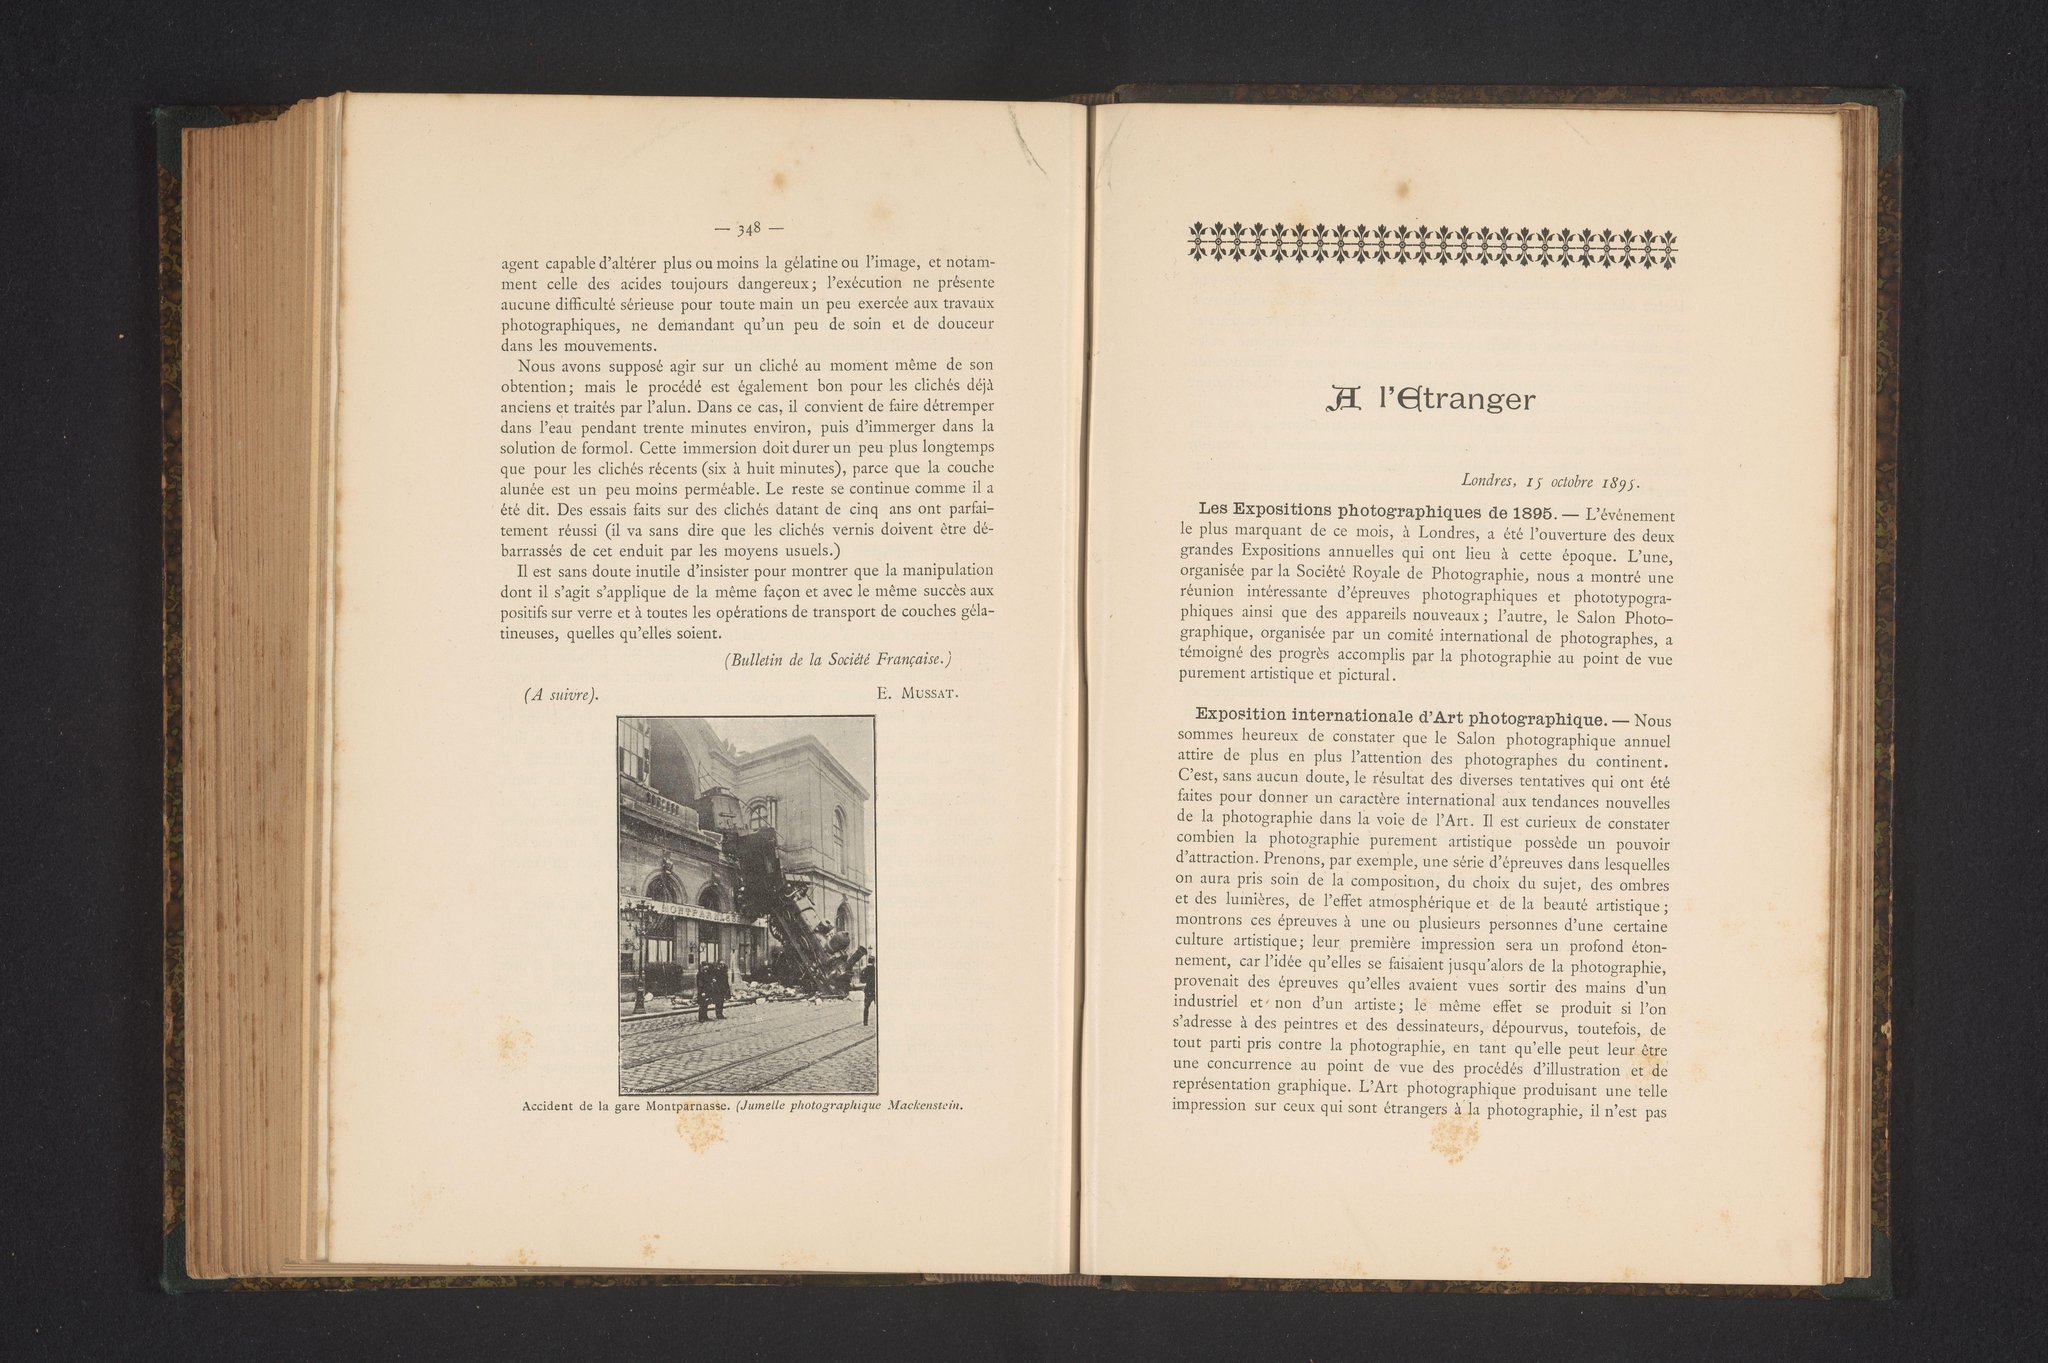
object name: photomechanical print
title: Accident de la gare Montparnasse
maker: Anonymous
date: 1890-1895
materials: paper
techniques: autotype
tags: accident with locomotive, station; shelter (railway, tramway)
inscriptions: inscription: ‘(Jumelle photographique Mackenstein.’